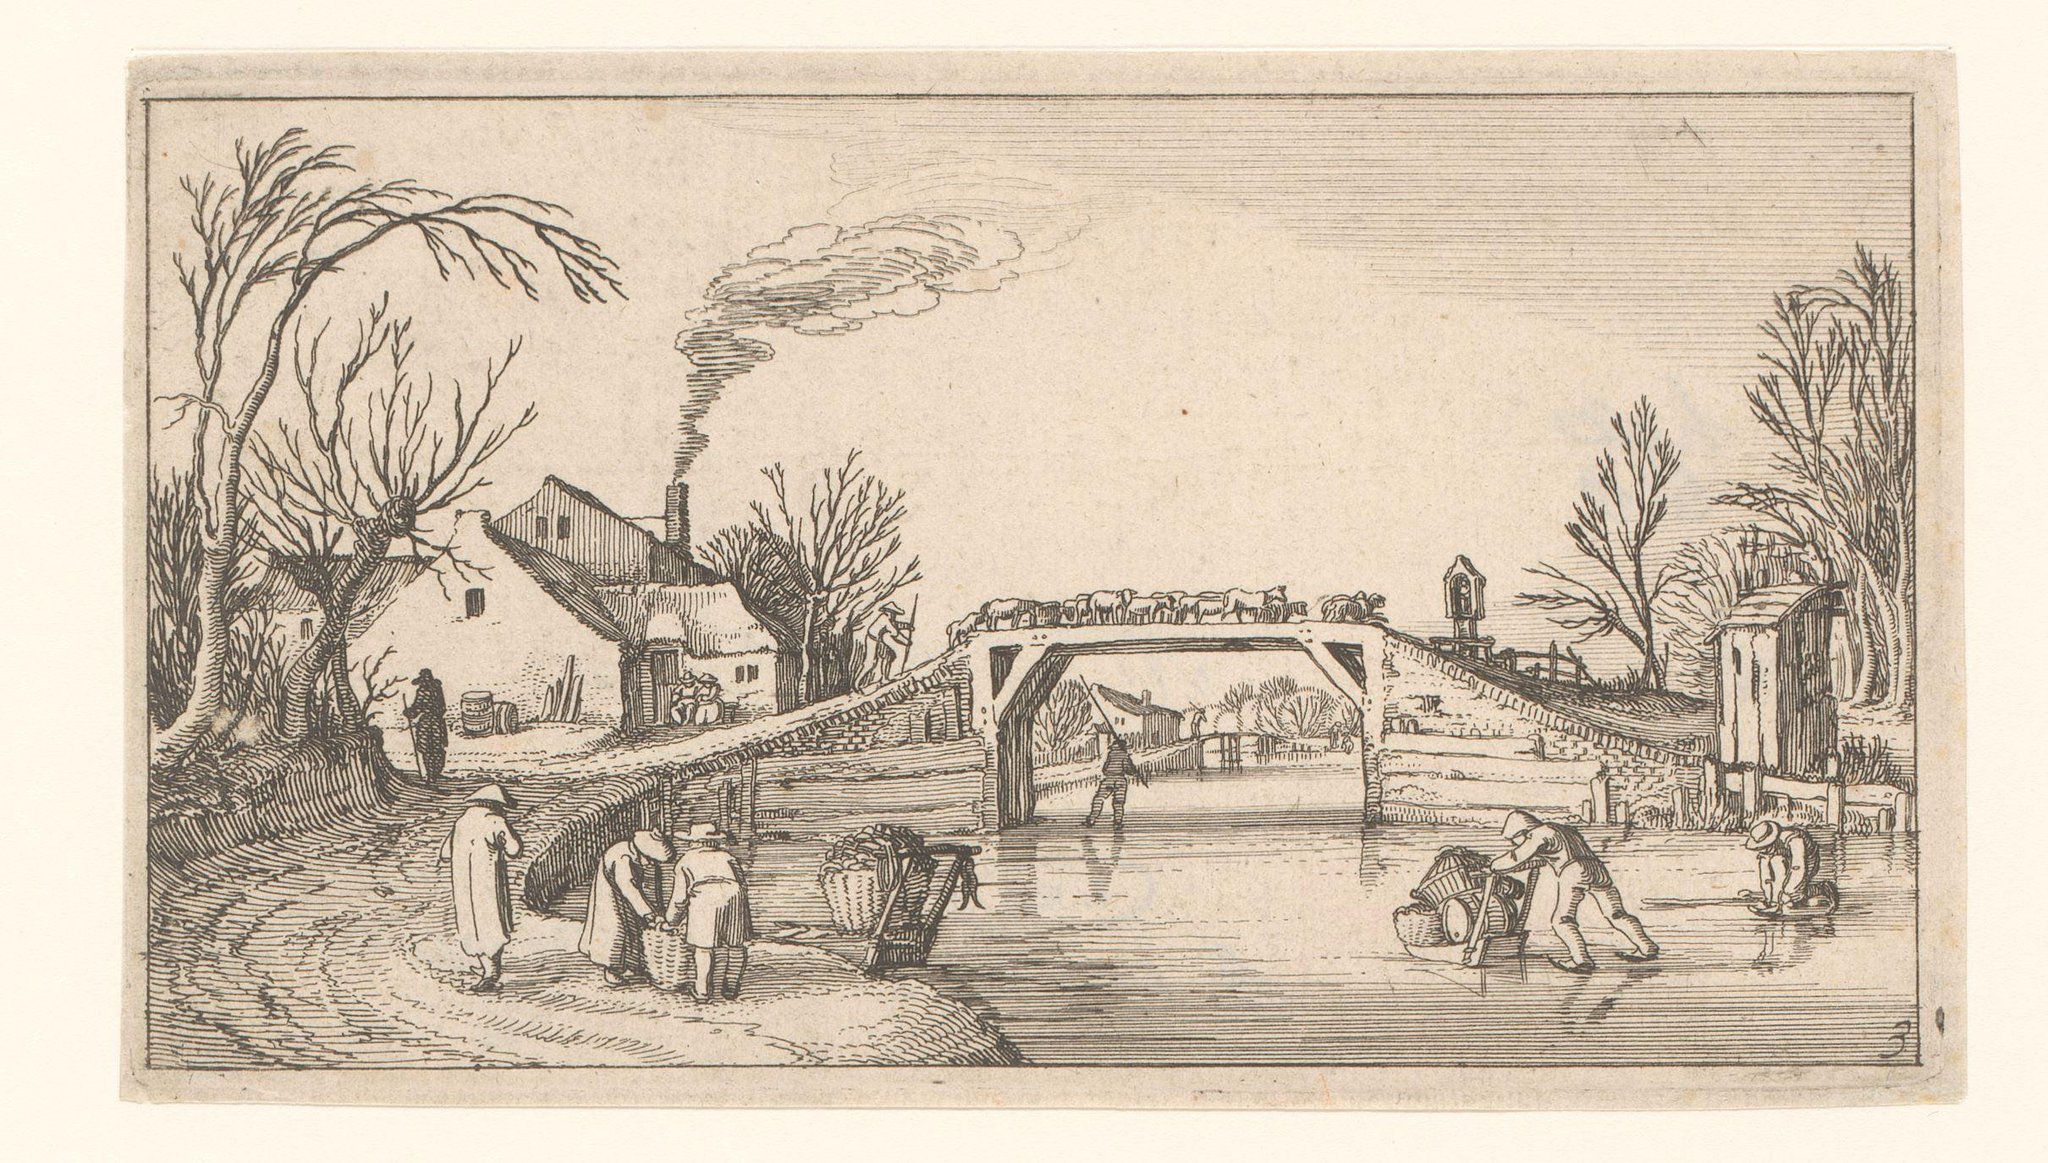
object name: print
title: Landschap met schaatsers bij een brug met schapen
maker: Anonymous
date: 1610-1650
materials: paper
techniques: etching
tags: landscape with bridge, viaduct or aqueduct, skates (winter sports), bridge, farm or solitary house in landscape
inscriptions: collector's mark: Lugt 2228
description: Maakt deel uit van een zesdelige serie met landschappen naar Esaias van de Velde.